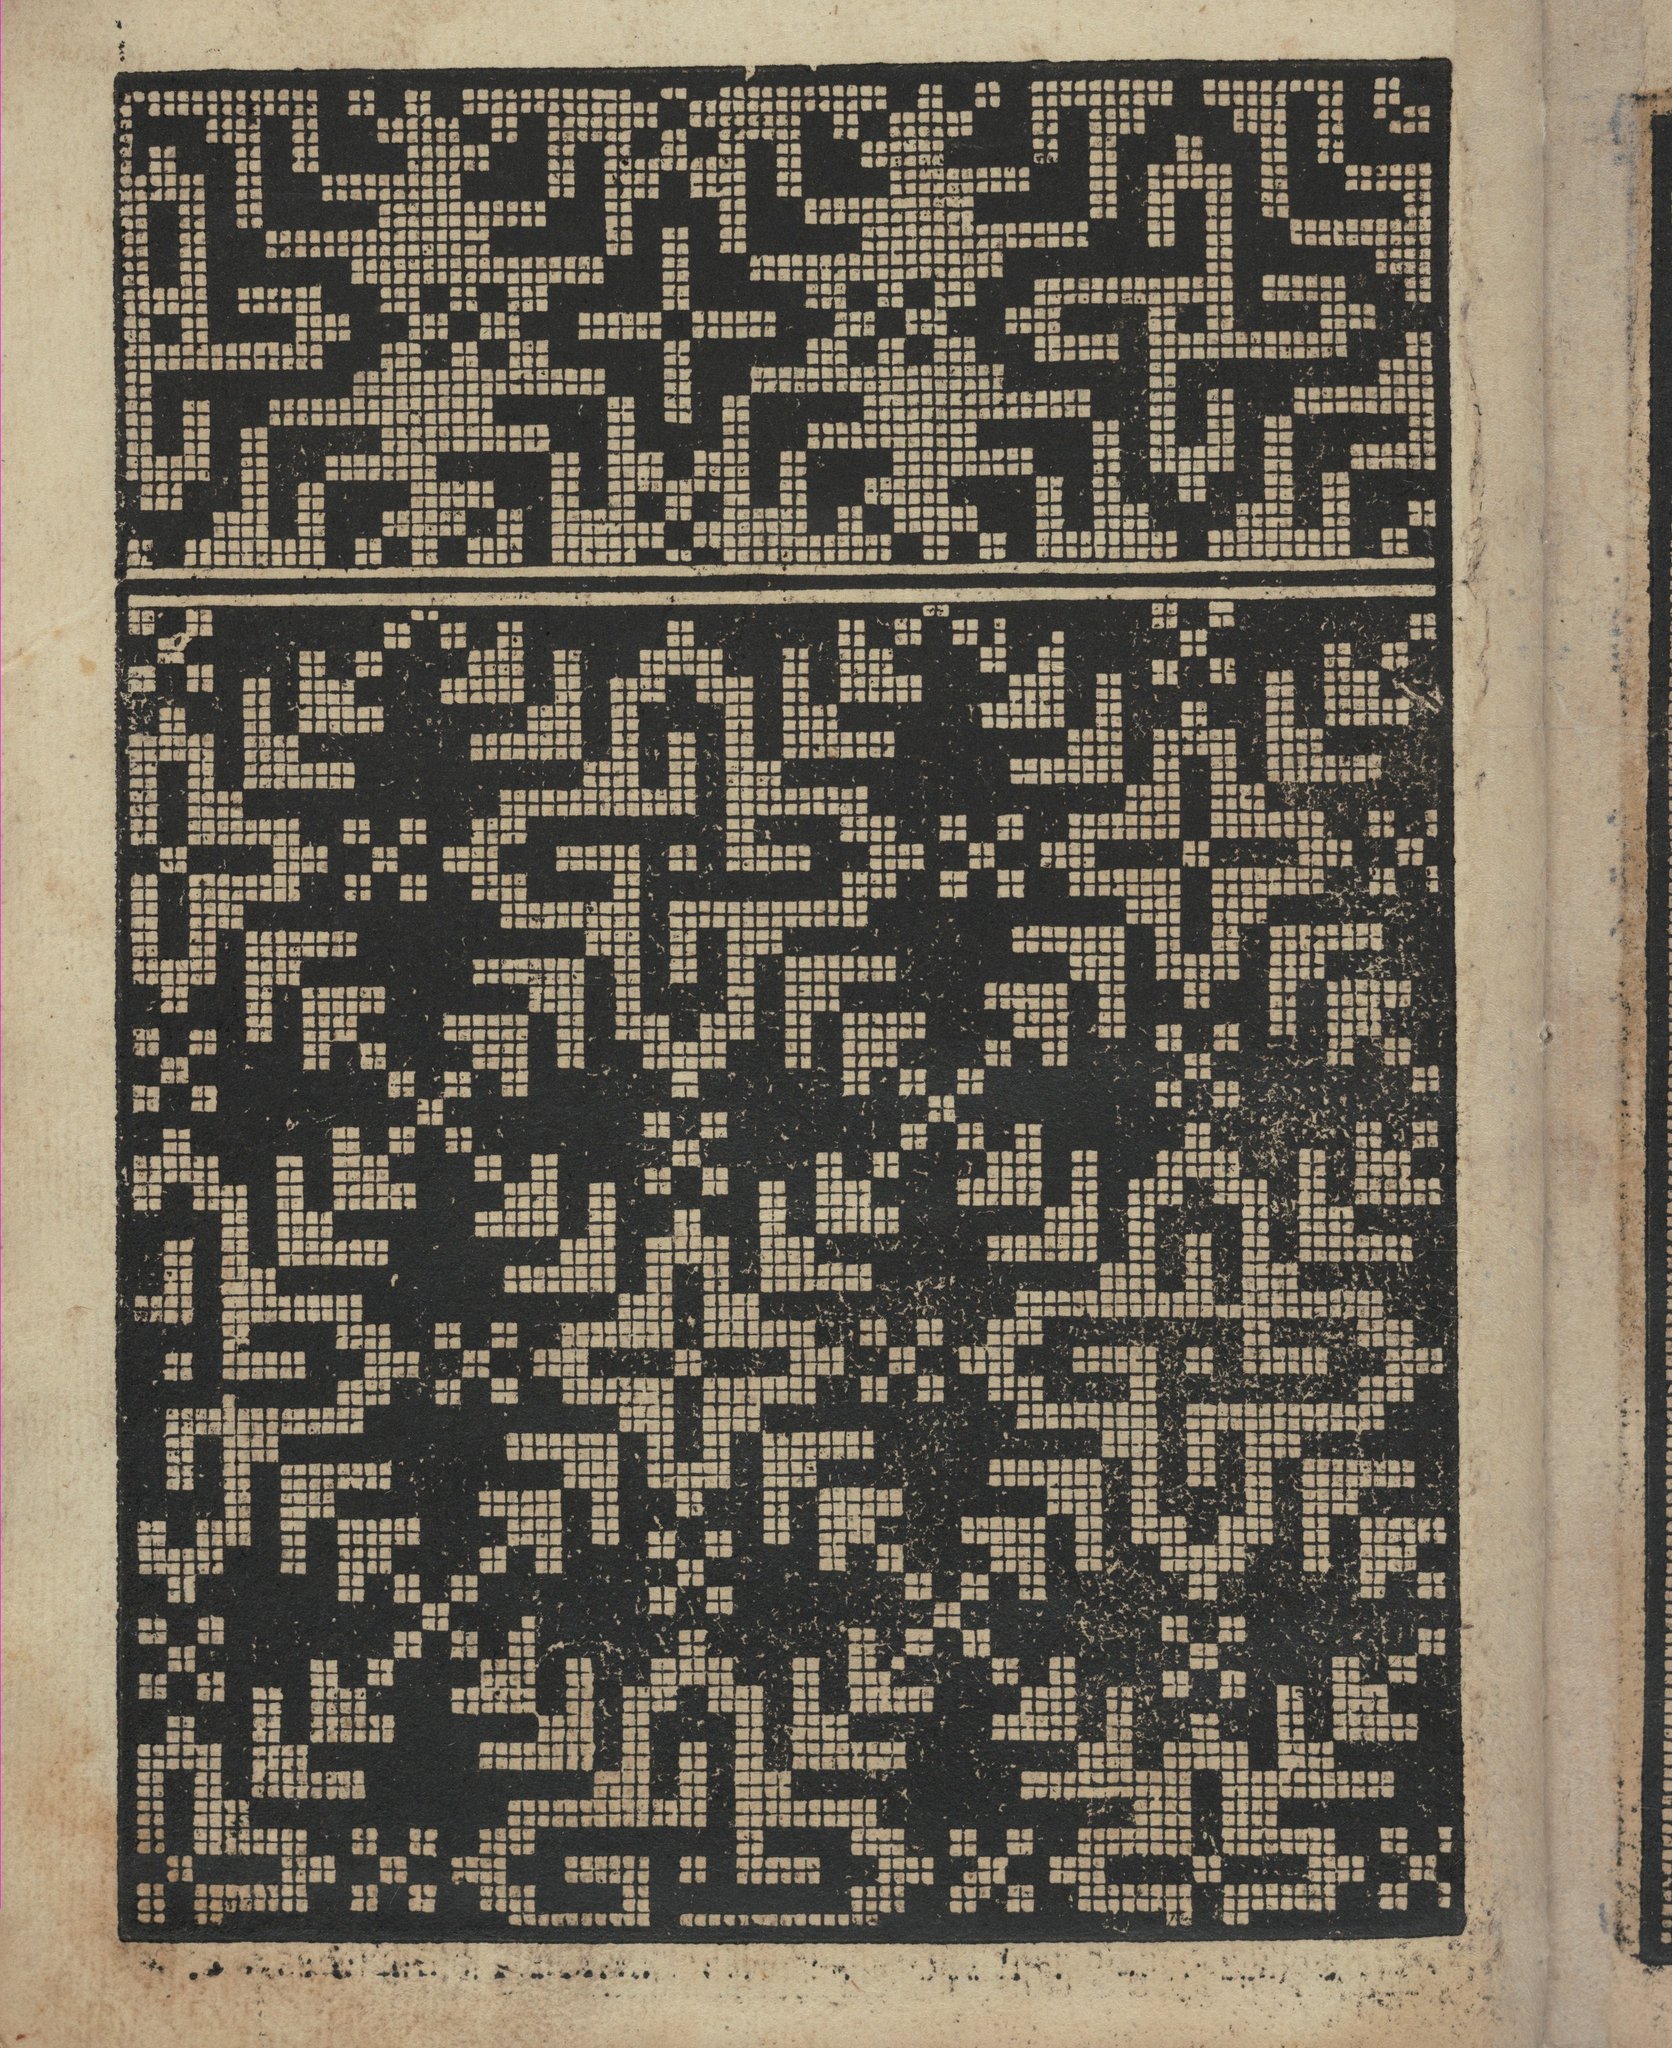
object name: book print ornament architecture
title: Libbretto nouellamete composto per maestro Domenico da Sera...lauorare di ogni sorte di punti, page 19 (verso)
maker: domenico da sera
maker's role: publisher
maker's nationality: french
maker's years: 1500-1599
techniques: woodcut